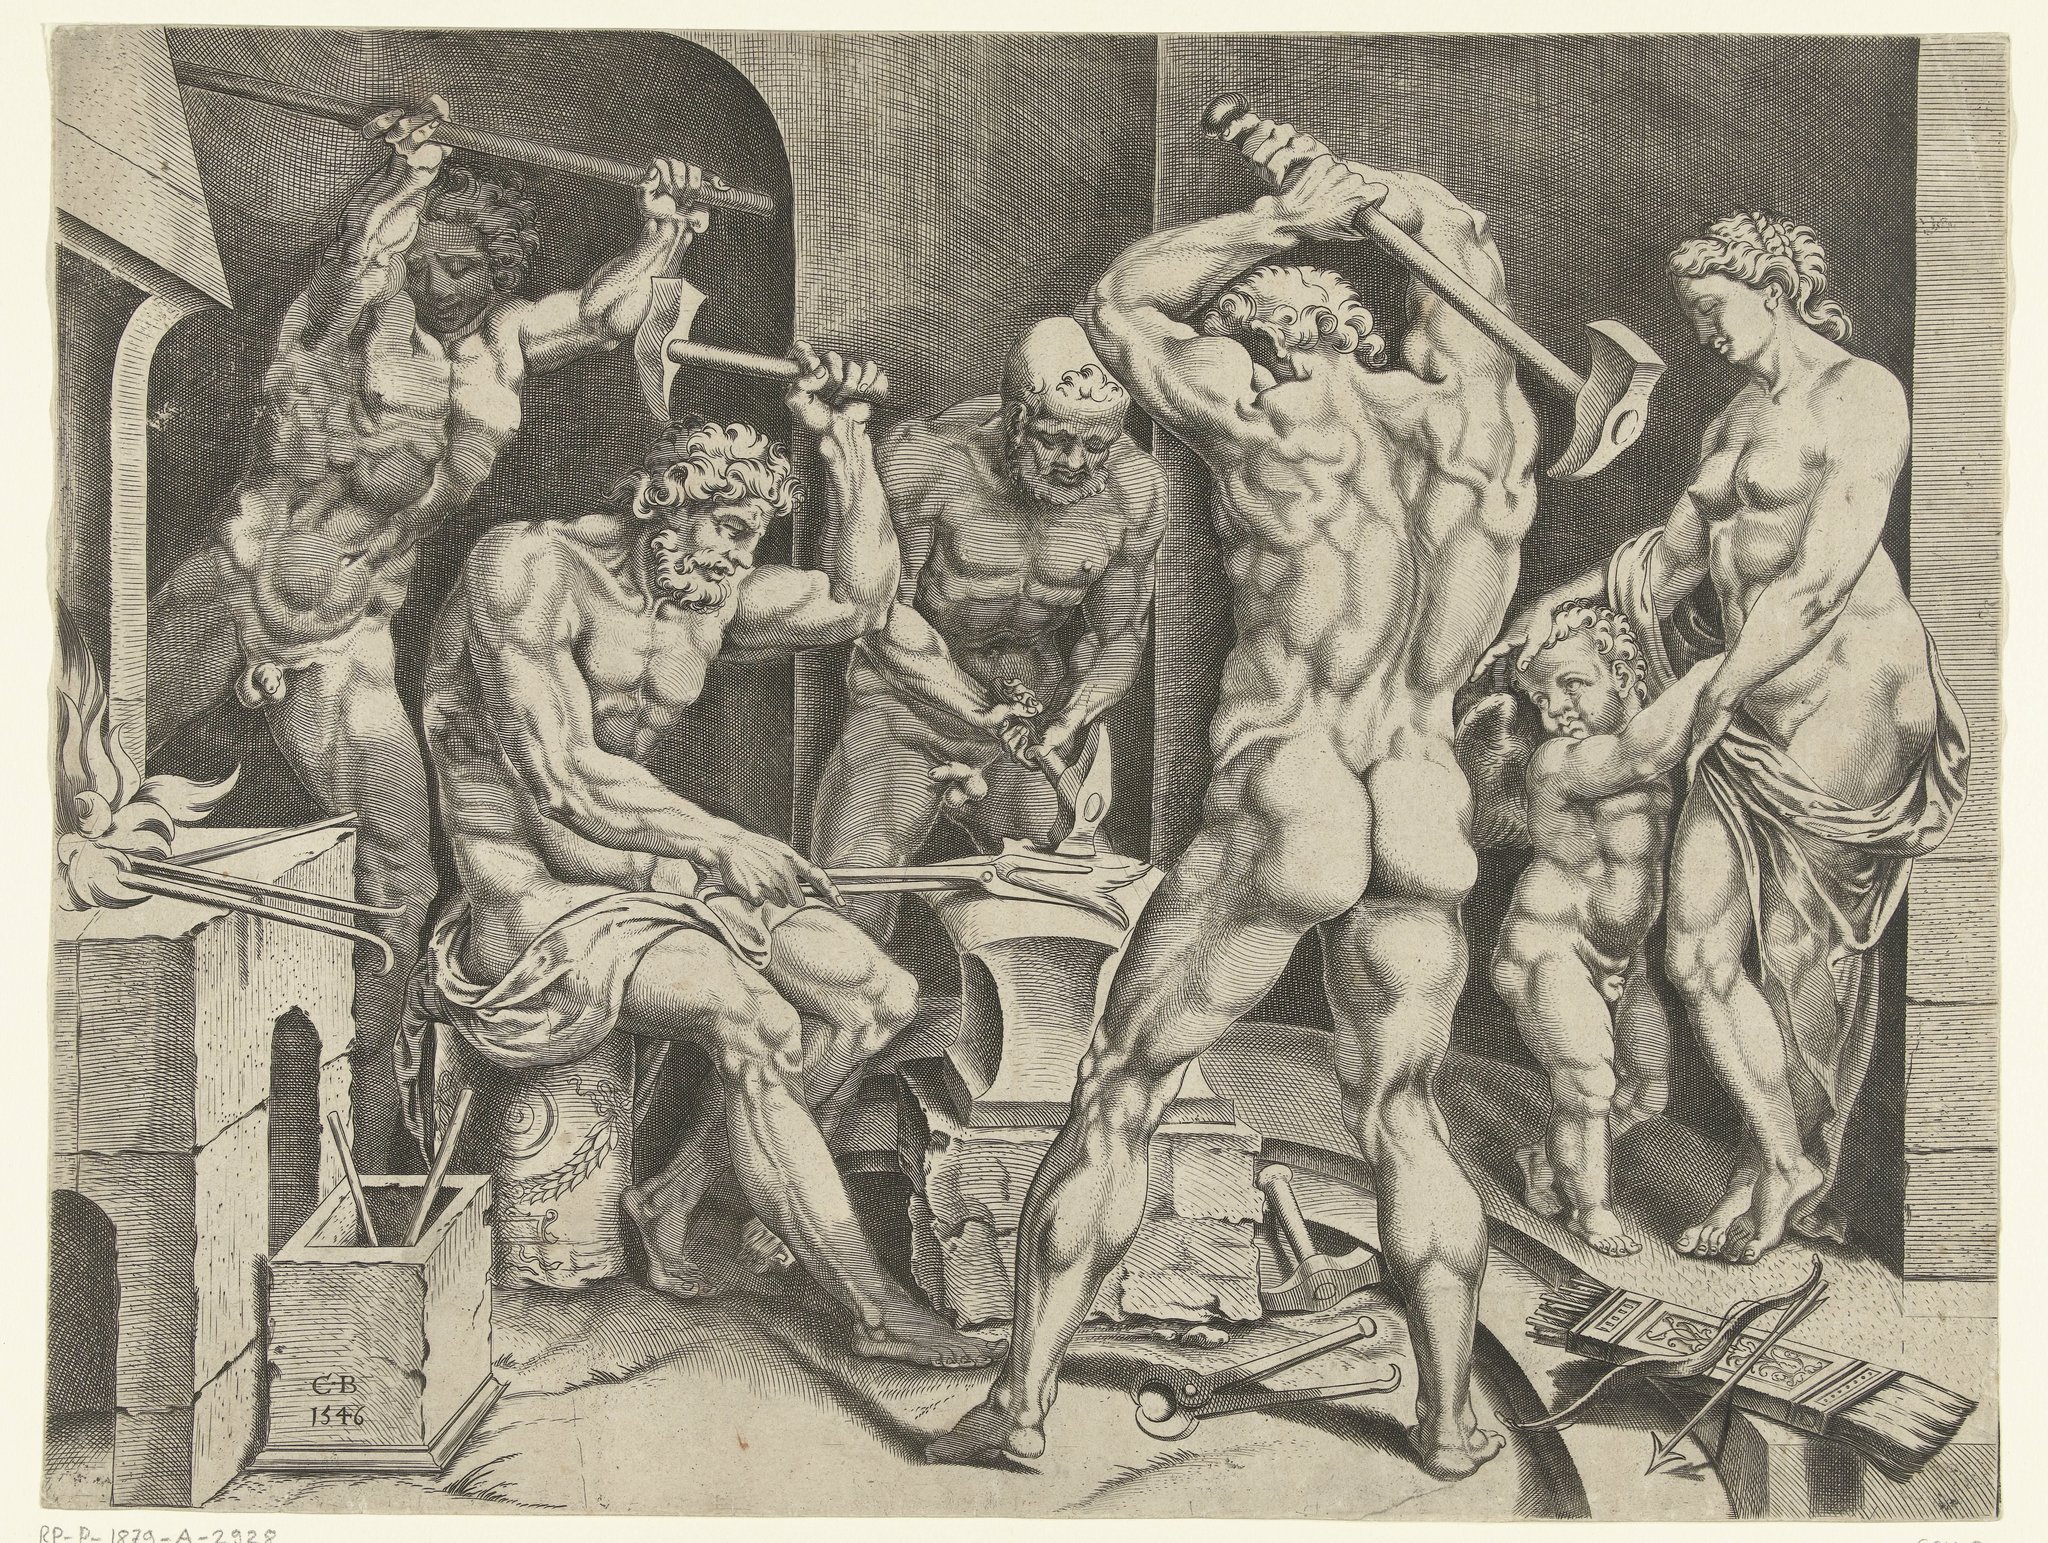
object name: print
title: Venus en Amor in de werkplaats van Vulcanus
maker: cornelis bos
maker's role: print maker, printer, publisher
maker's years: 1510-1566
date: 1546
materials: paper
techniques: engraving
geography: nuremberg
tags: vulcan forges cupid's wings and arrows, vulcan and venus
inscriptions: collector's mark: Lugt 2228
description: Vulcanus zit bij een aambeeld en smeedt met behulp van twee naakte cyclopen de vleugels van Amor. Links is een derde cycloop bezig het vuur aan te wakkeren. Rechts staan Venus en Amor ernaar te kijken. Amors pijl en boog liggen rechts op de grond.